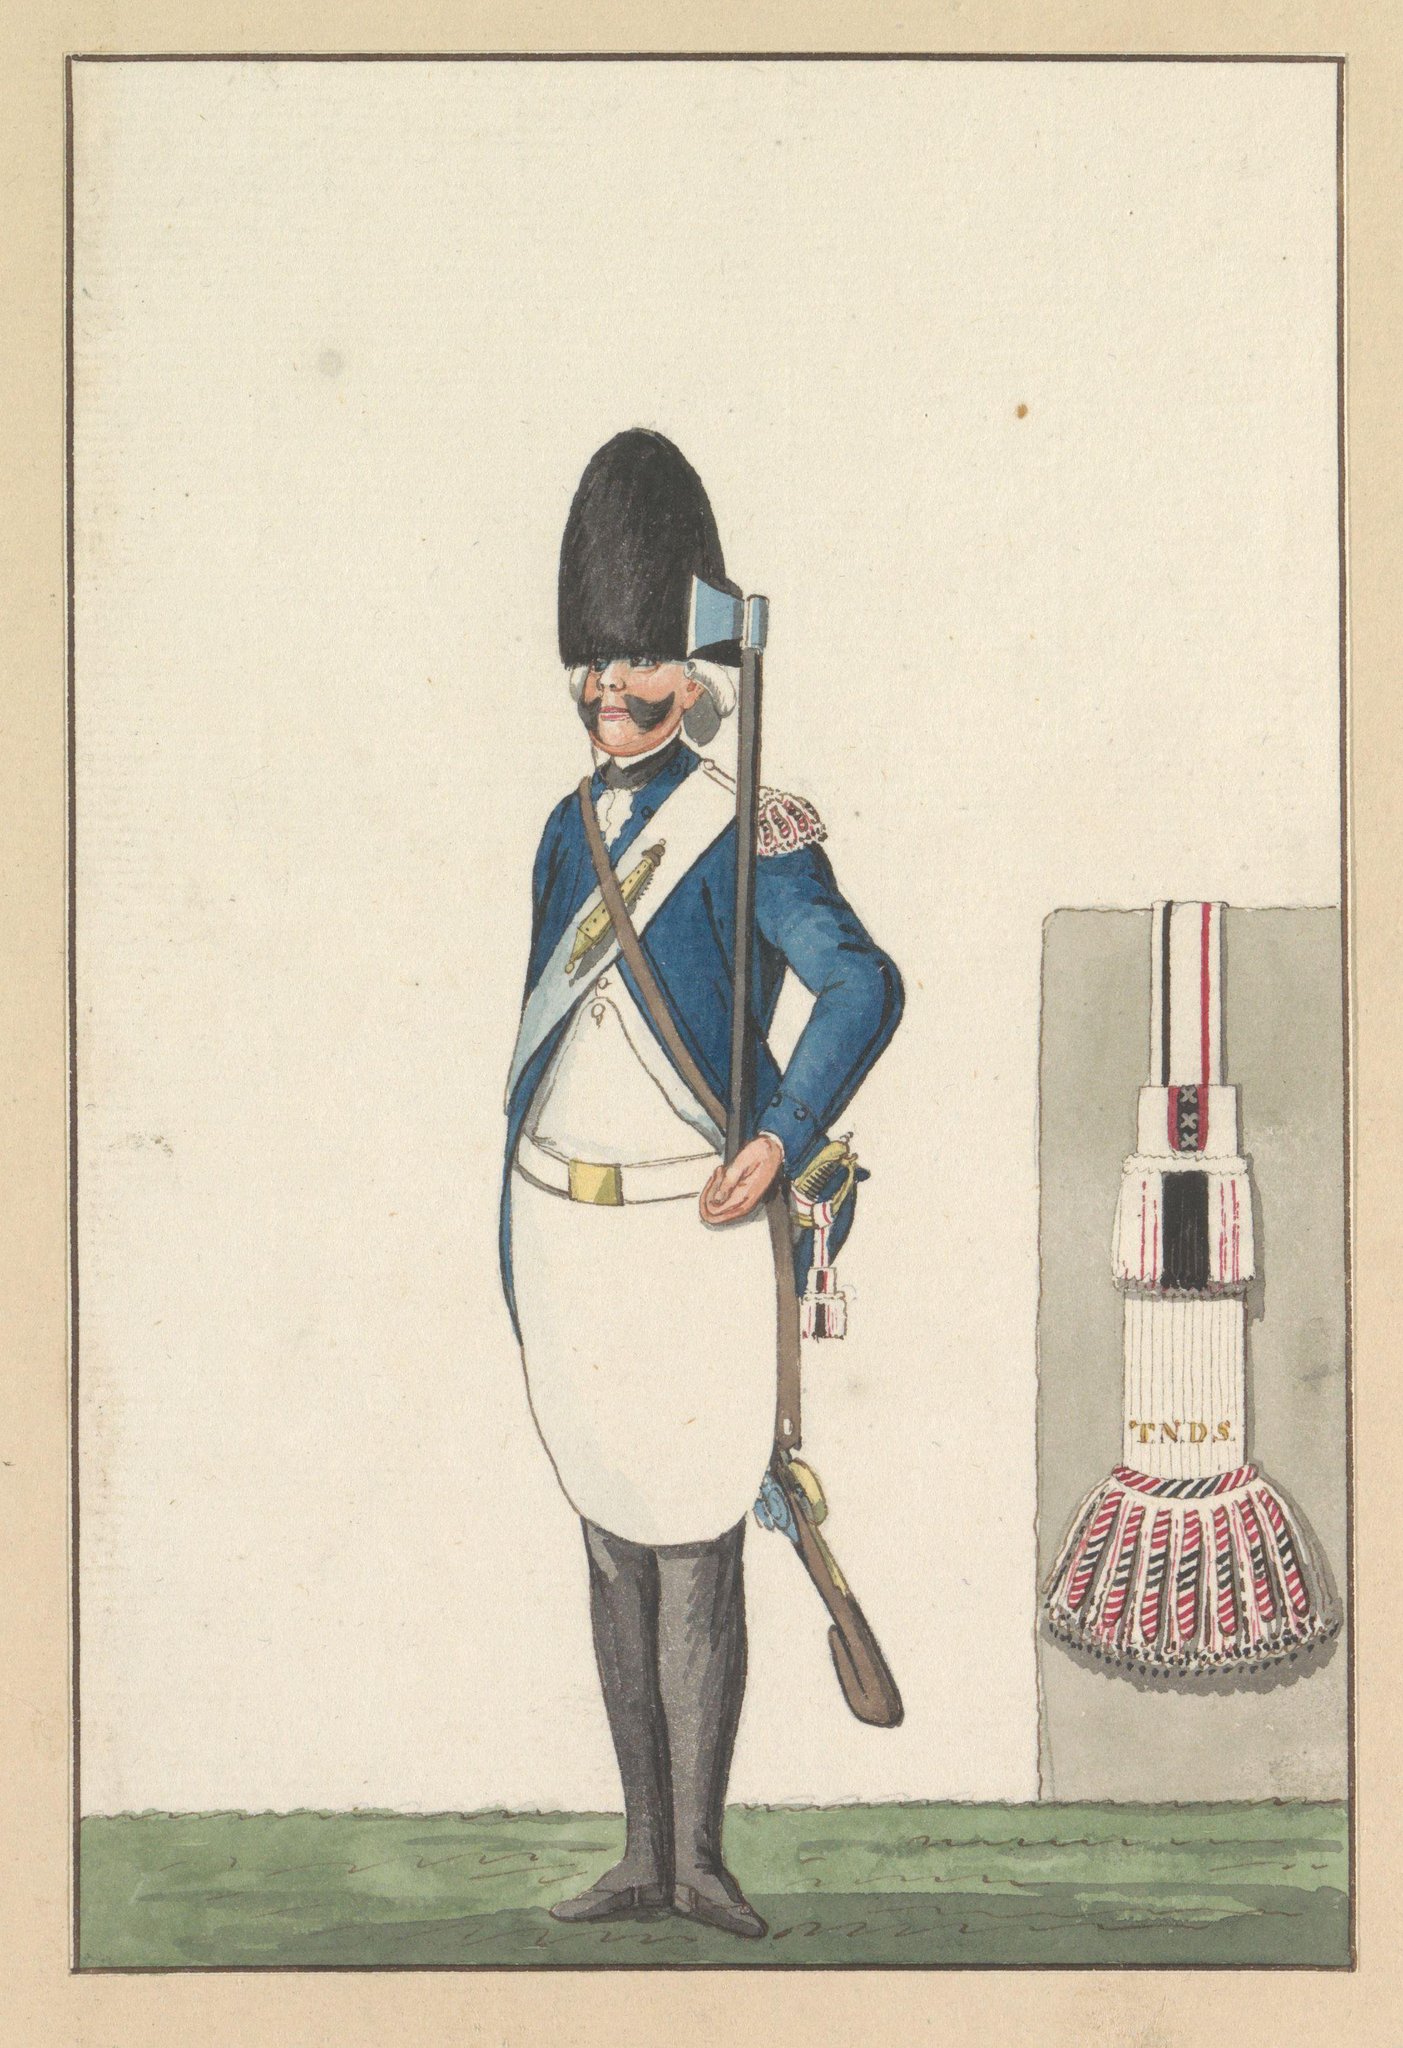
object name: drawing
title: Sappeur van het Genootschap tot Nut der Schutterij te Amsterdam, 1787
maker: Anonymous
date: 1787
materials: paper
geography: amsterdam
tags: (military) uniforms (+ citizen soldiery, civil guard, citizen militia), amsterdam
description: Sappeur, staande met een bijl in de linkerhand rustend op de schouder. Rechts een detail van de sabelkwast en het uiteinde van de epaulet. Onderdeel van het album met veertien ingeplakte gekleurde tekeningen van de uniformen van schutters van het patriotse Genootschap tot Nut der Schutterij te Amsterdam in het jaar 1787.